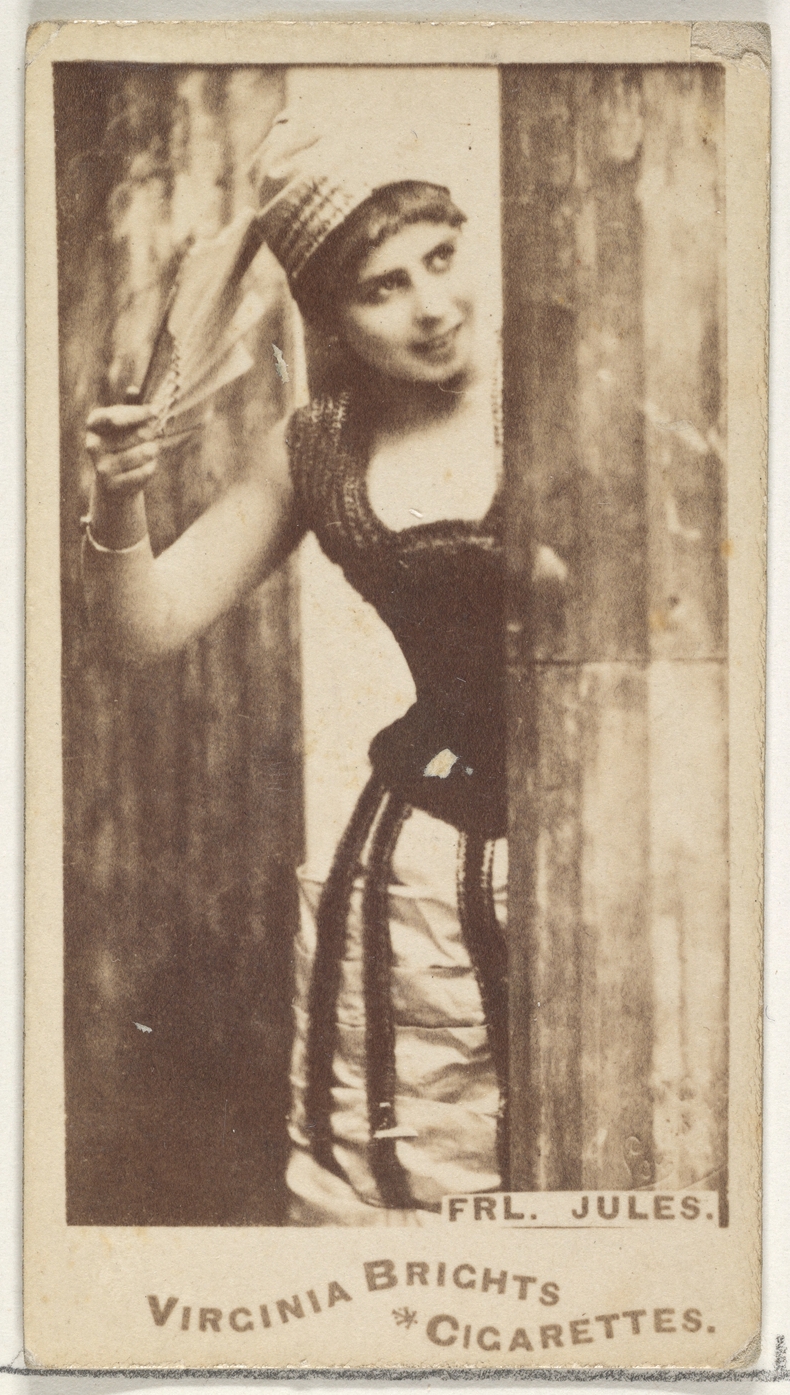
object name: photograph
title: Fräulein Jules, from the Actors and Actresses series (N45, Type 1) for Virginia Brights Cigarettes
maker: allen & ginter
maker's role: publisher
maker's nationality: american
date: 1888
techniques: albumen silver print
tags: portraits,women,actresses